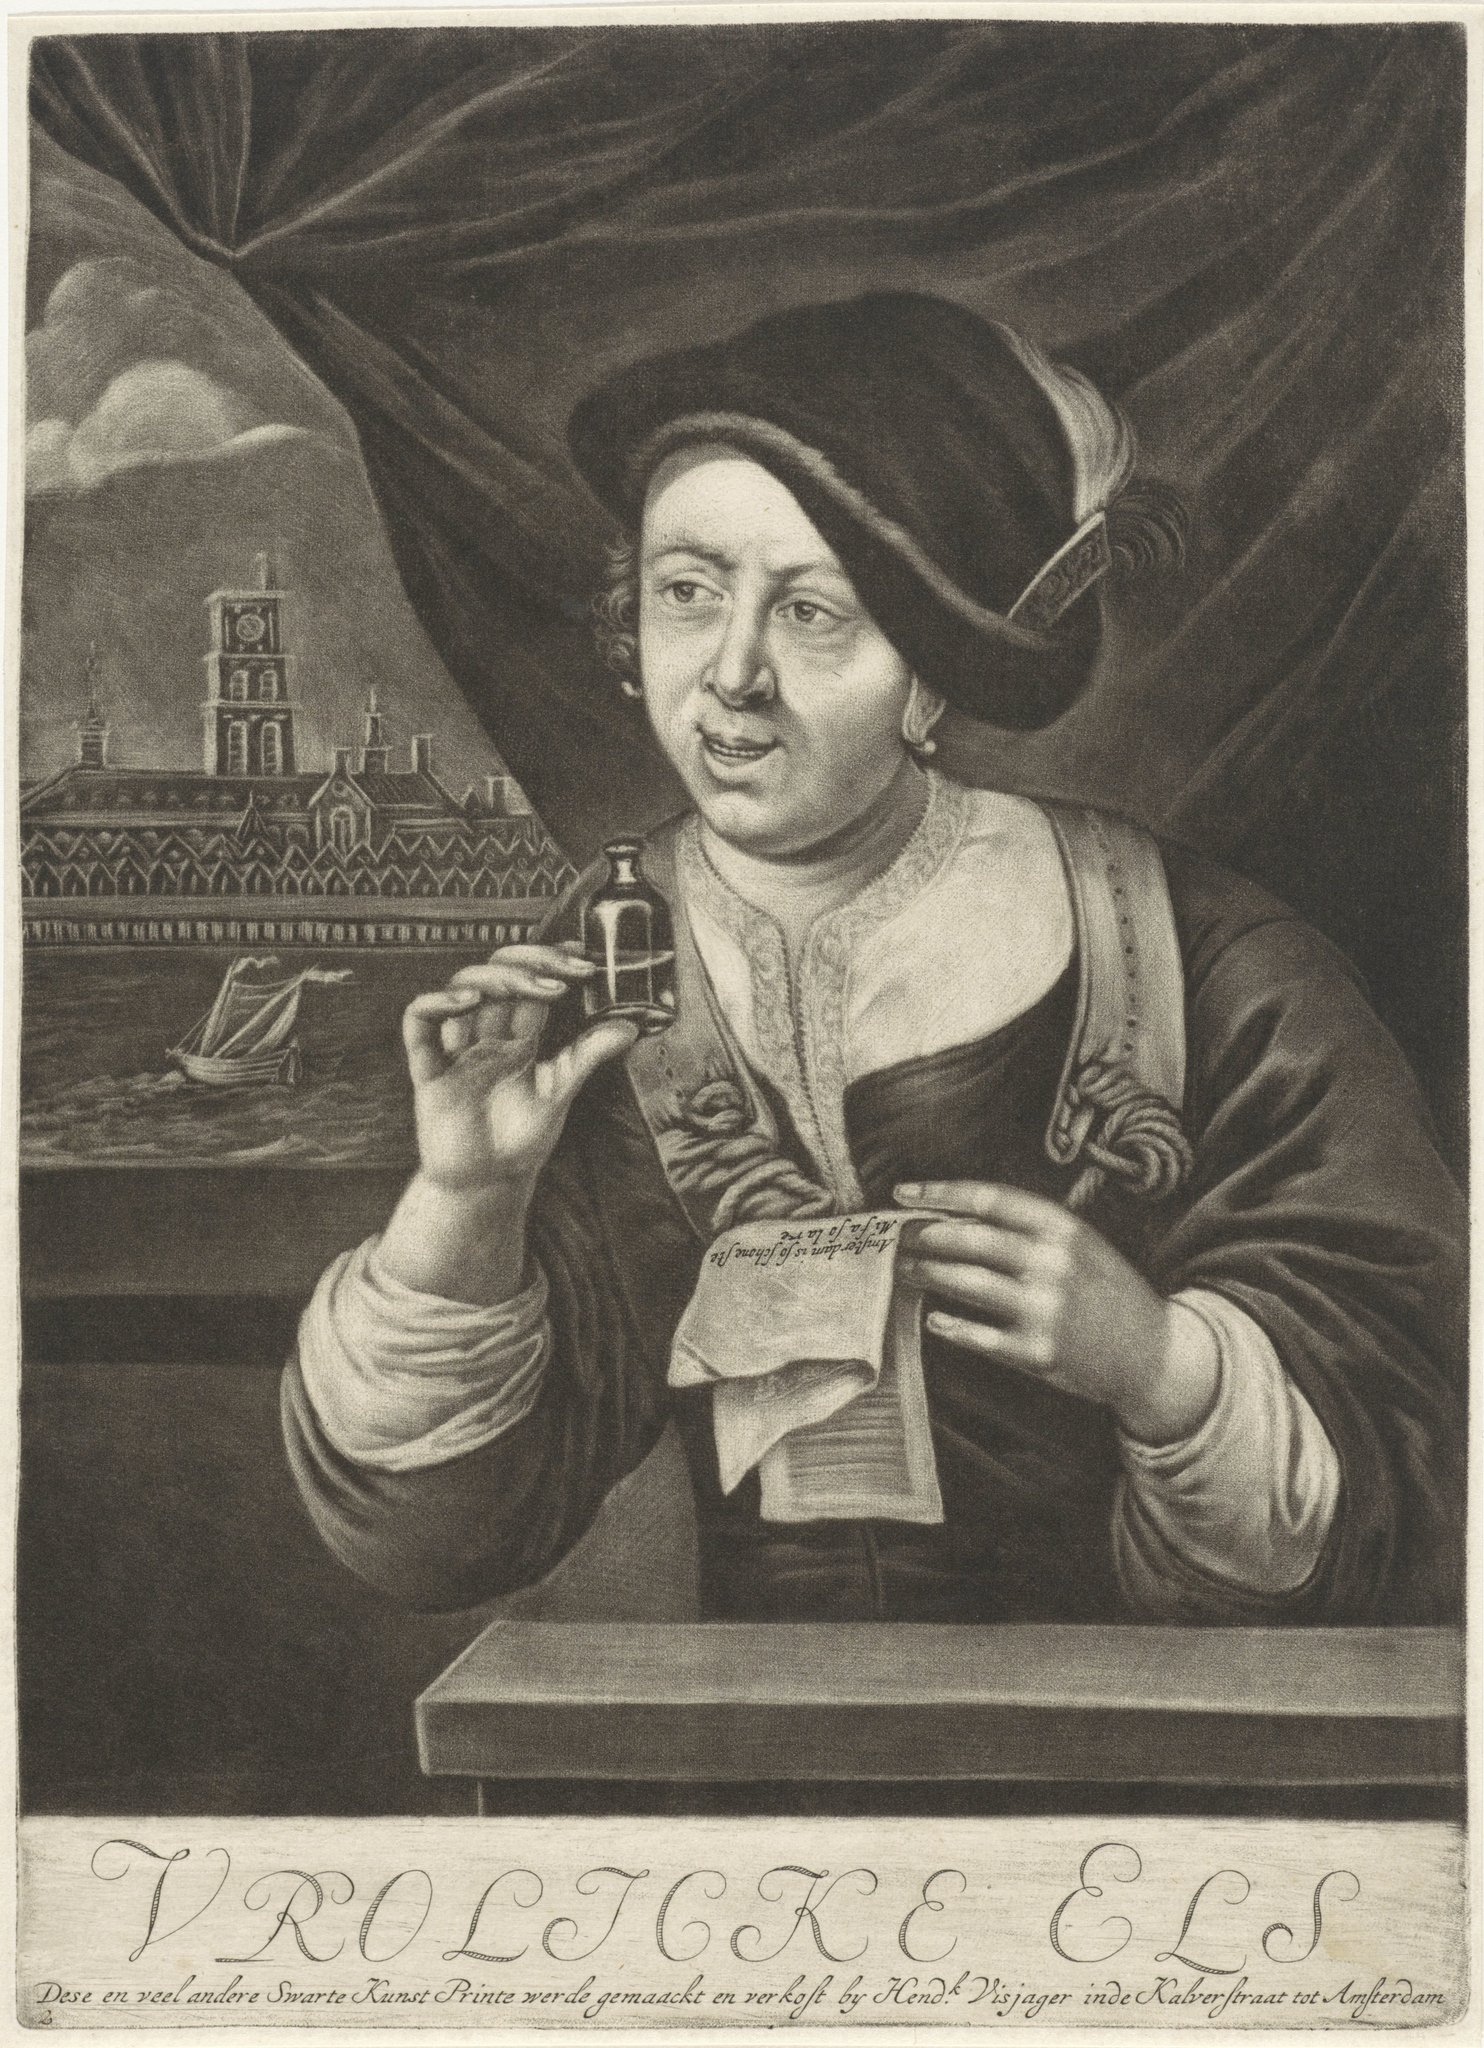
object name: print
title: Zingende vrouw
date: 1683-1684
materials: paper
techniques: mezzotint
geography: amsterdam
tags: city-view in general; 'veduta', river, vocal music, singing, drinking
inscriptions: collector's mark: Lugt 2228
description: 'Vrolijke Els' zingt van een blad waarop: Amsterdam is so schone ste/ Mi fa so la re. In haar hand heeft ze flacon. Op de achtergrond een rivier met een zeilschip waarachter een stad.